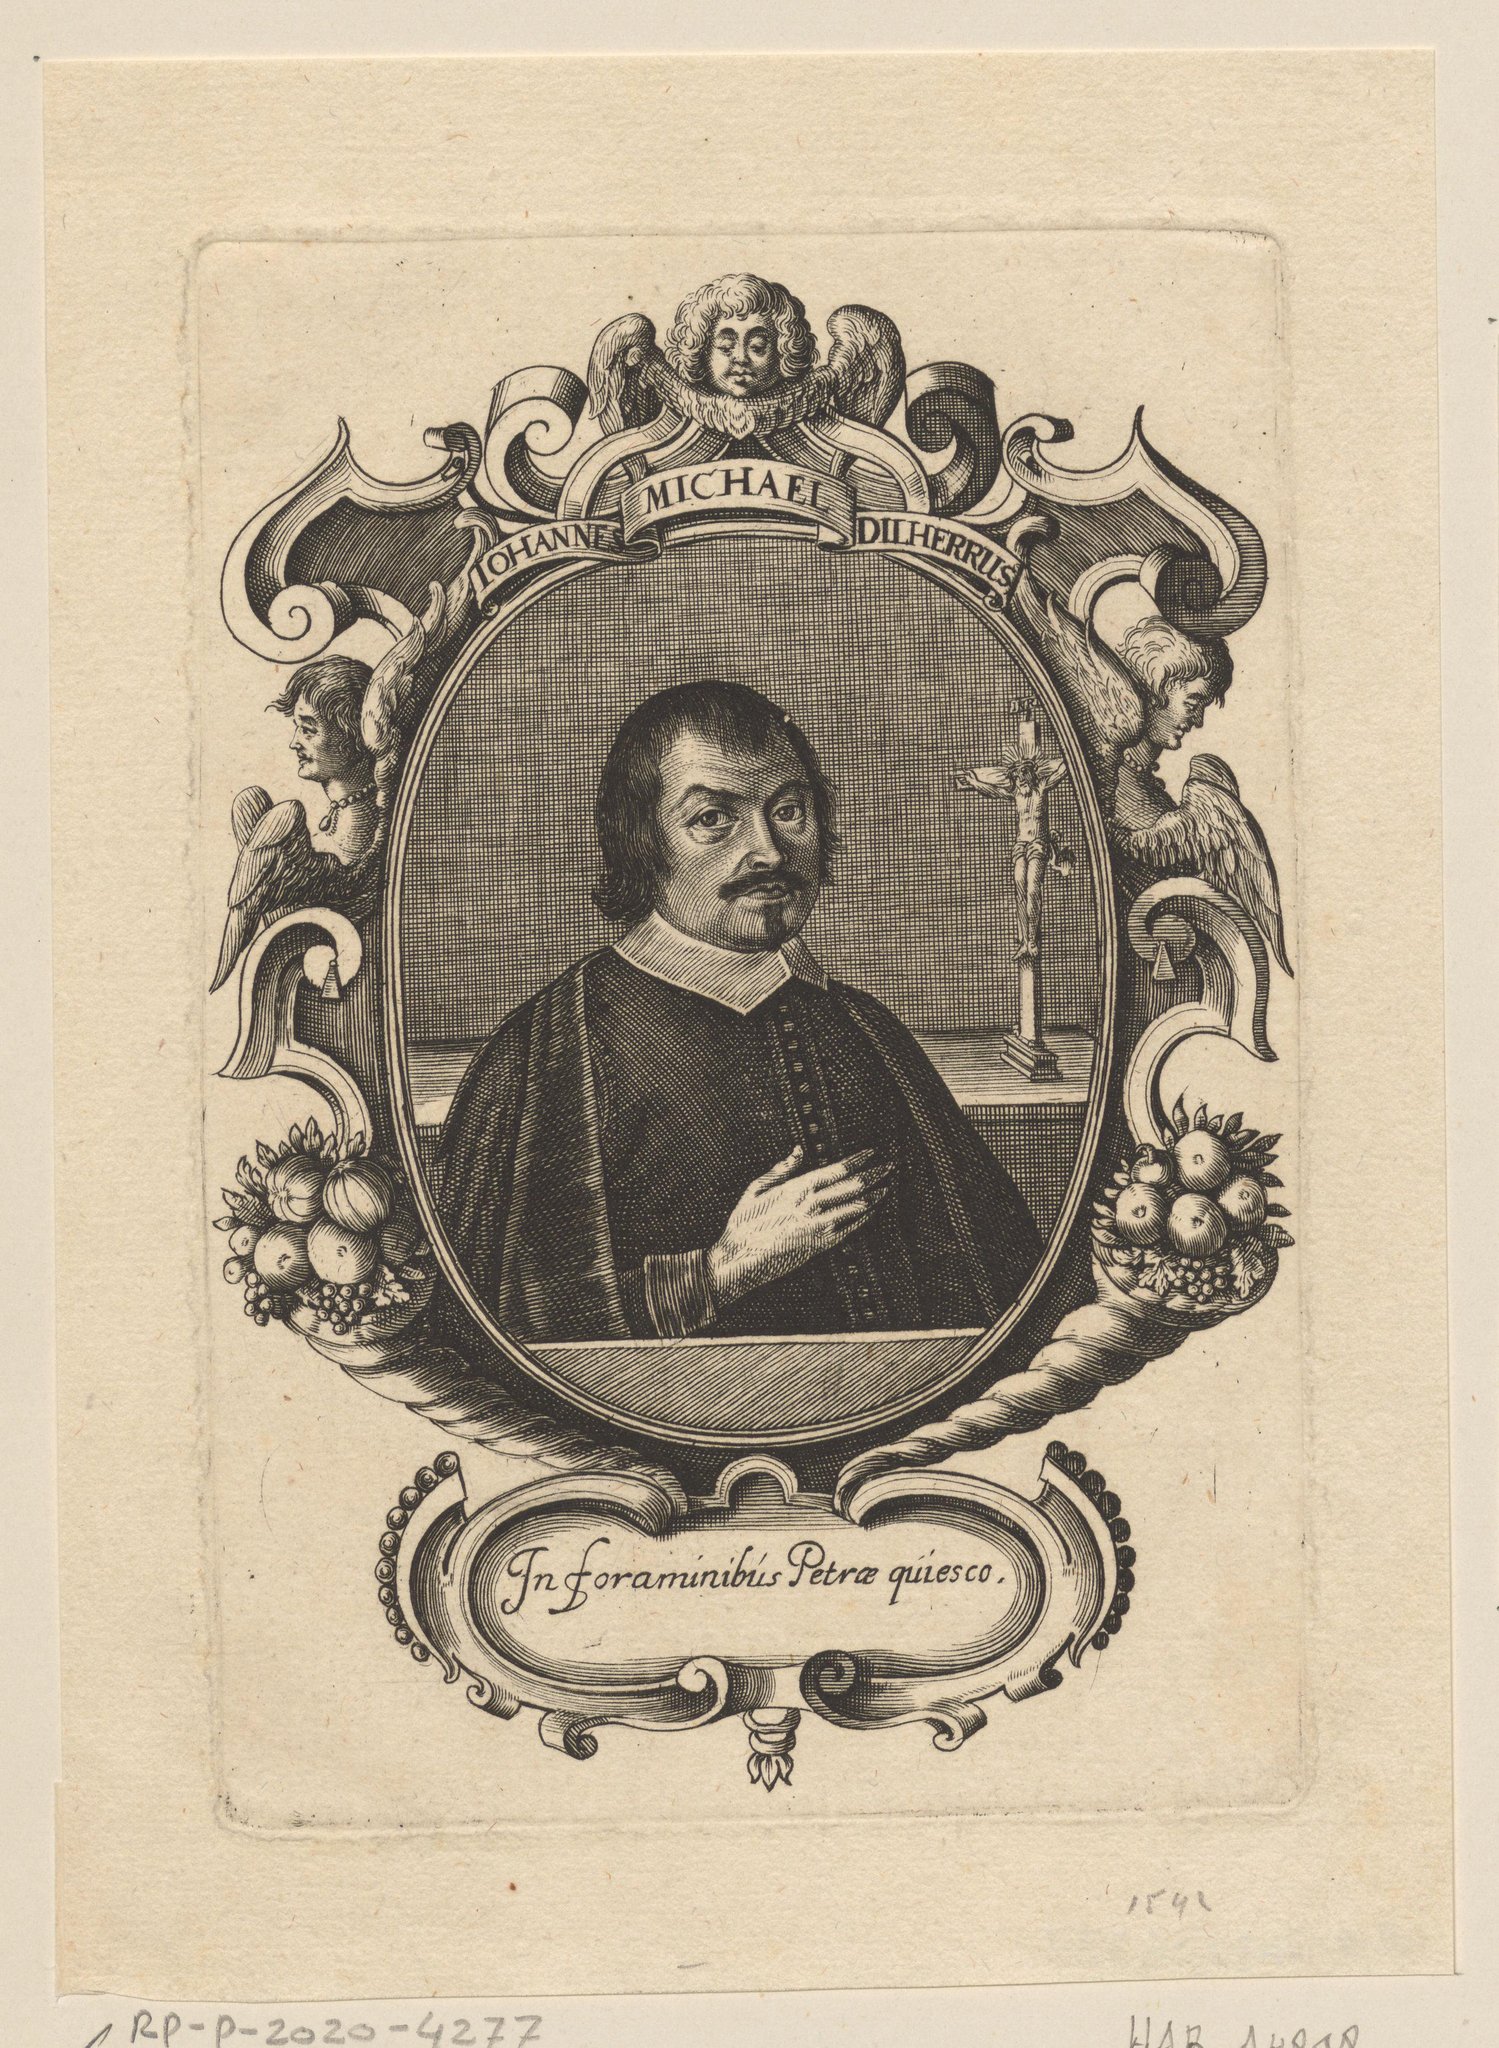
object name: print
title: Portret van Johann Michael Dilherr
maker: Anonymous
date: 1634-1700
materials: paper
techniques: engraving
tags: johann michael dilherr, 'cornucopia', horn of plenty, theologian, historical persons, crucifix ~ personal devotion, angels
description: In een ovaal met in de rand drie engelen en aan beide zijden een hoorn des overvloeds. Achter de geportretteerde staat een crucifix.